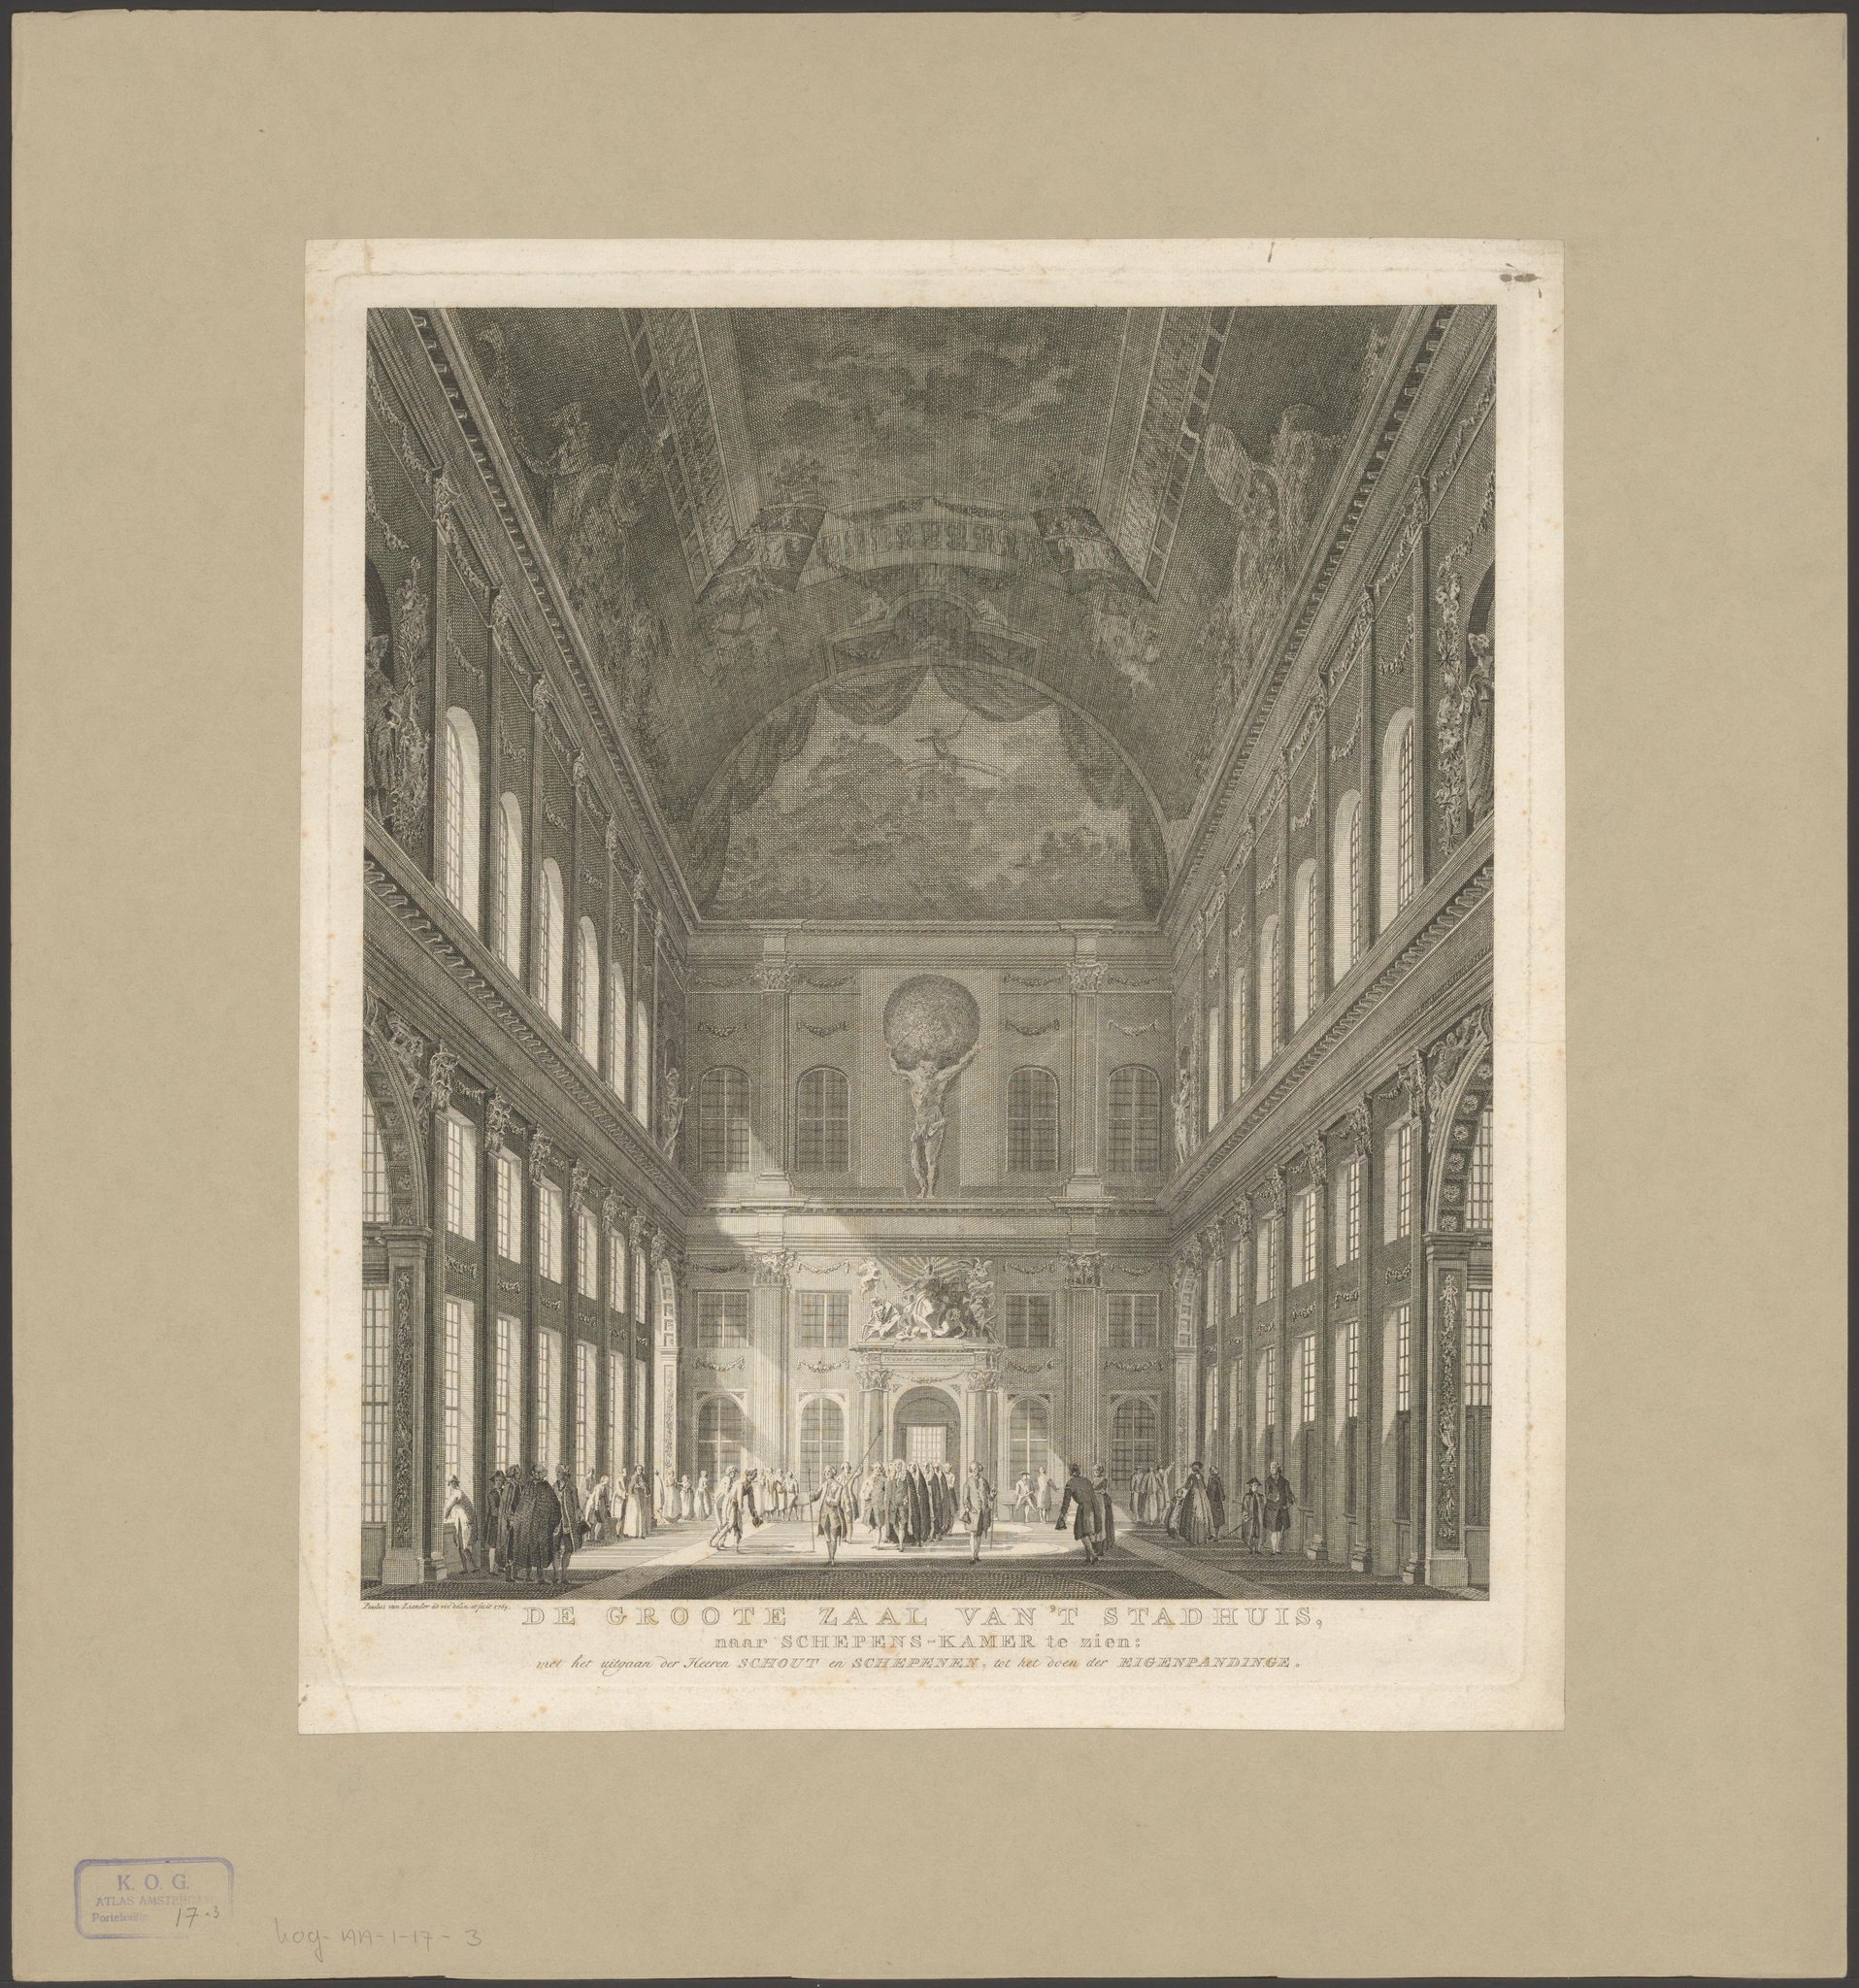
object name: print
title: Gezicht op de westzijde van de Burgerzaal in het Stadhuis op de Dam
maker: paulus van liender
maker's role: draughtsman, print maker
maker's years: 1731-1797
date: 1765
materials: paper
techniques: etching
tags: (story of) atlas, townhall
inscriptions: collector's mark: ‘17.3’ Lugt 1641b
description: Onderwerpsrubriek binnen de Atlas Amsterdam: Nieuwe Stadhuis, van binnen: Groote zaal, Raadkamer, Schepenkamer, Troonzaal, Mozeszaal, Zitkamer.